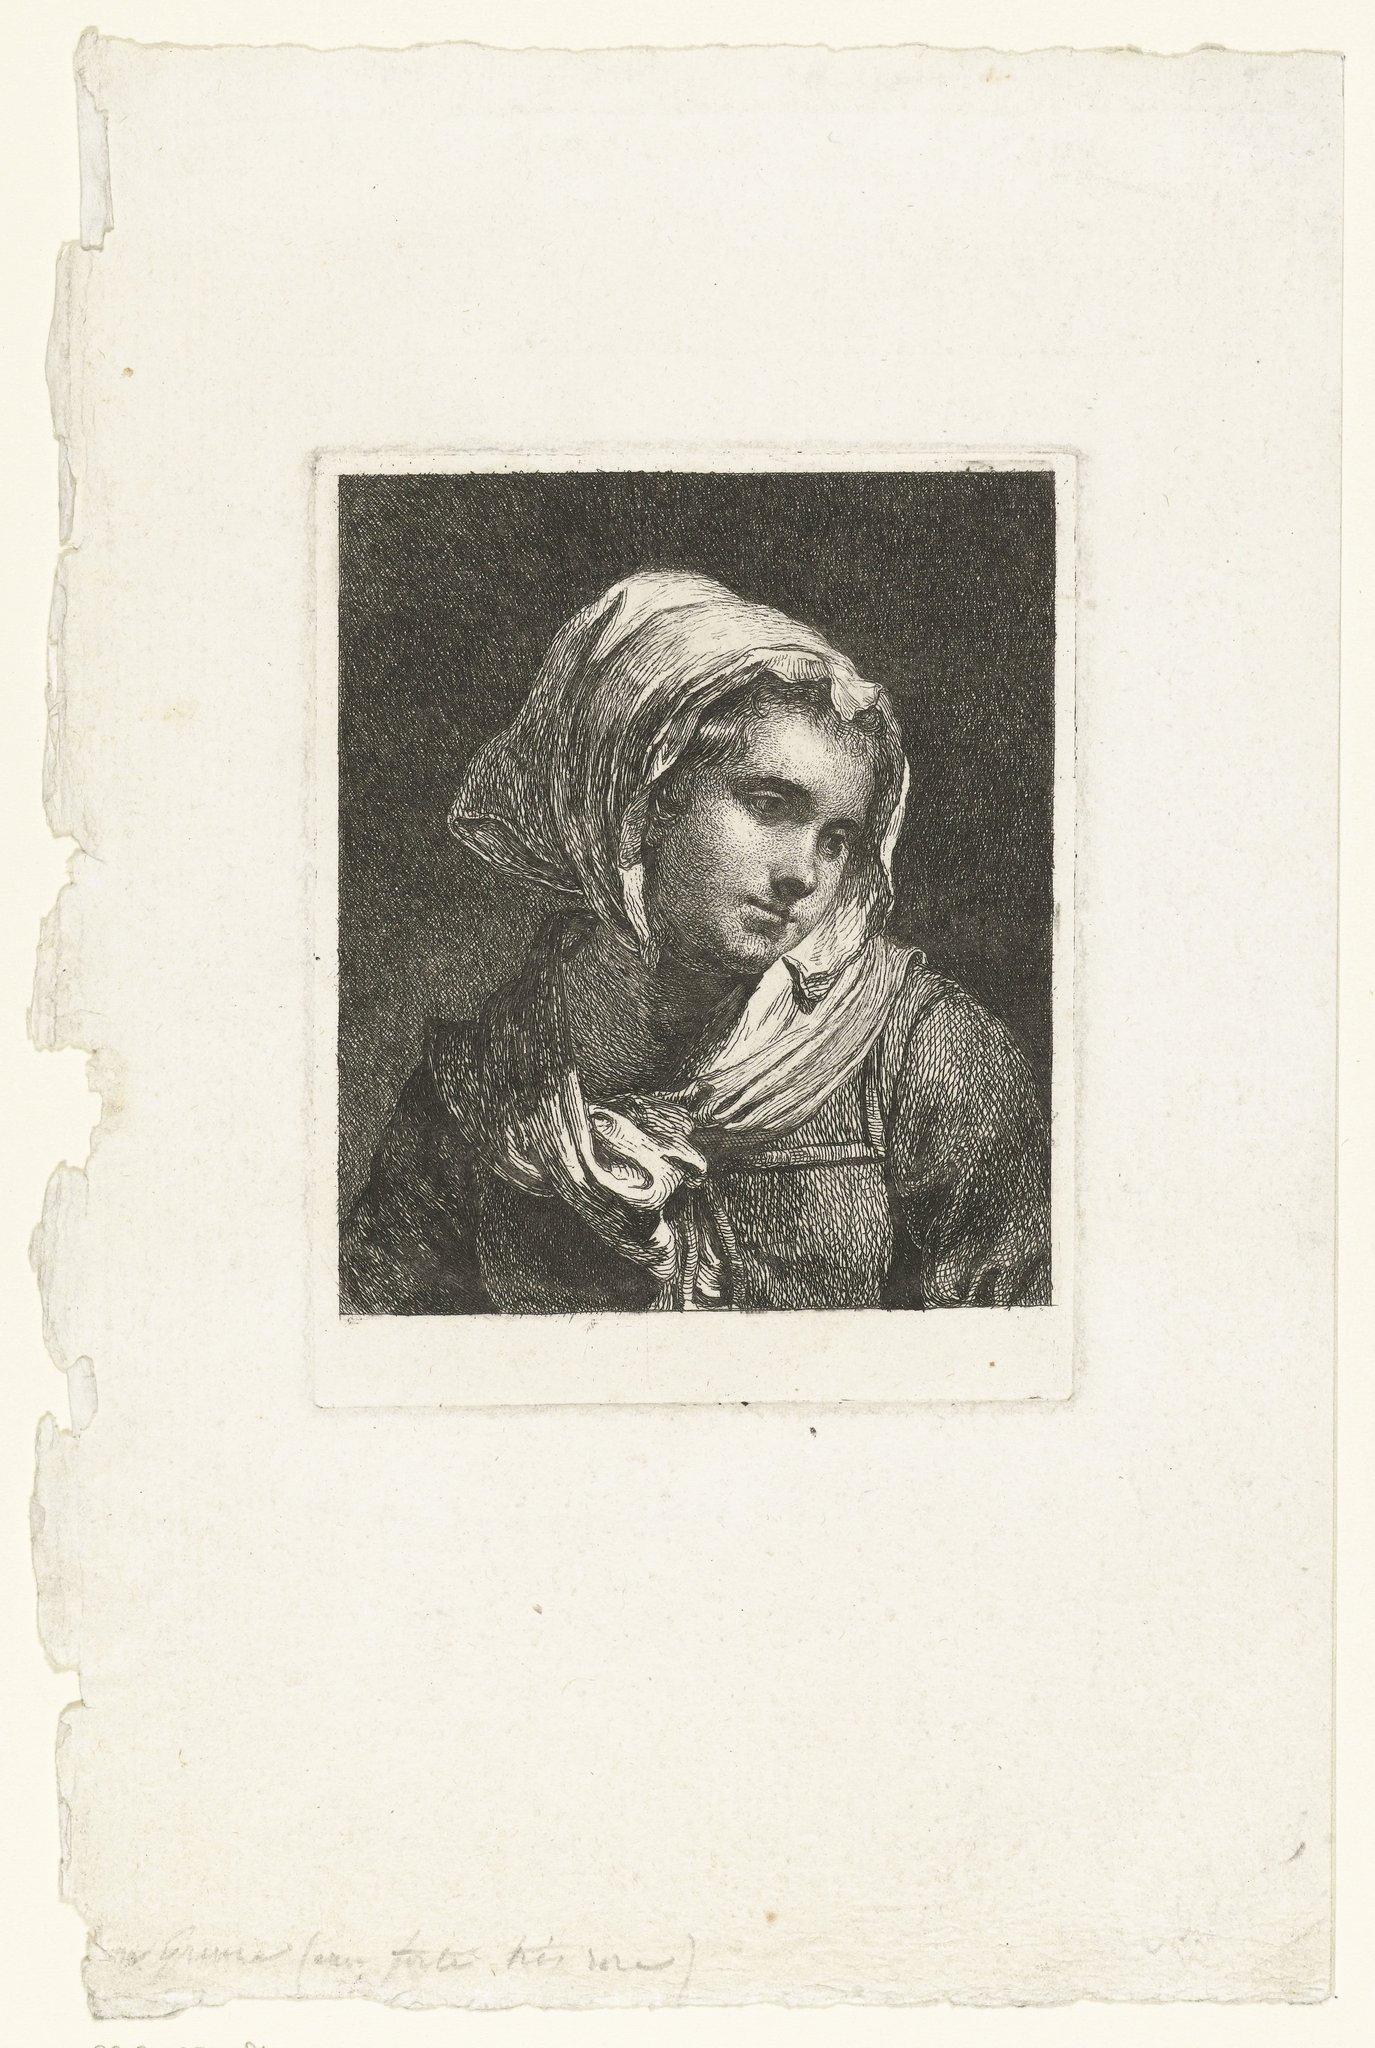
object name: print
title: La Savoyarde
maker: jean-baptiste greuze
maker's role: painter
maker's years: 1725-1805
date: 1735-1805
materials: paper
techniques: etching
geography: france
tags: adolescent, young woman, maiden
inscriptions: collector's mark: Lugt 2228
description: Buste van een meisje met een sjaal en hoofddoek om.